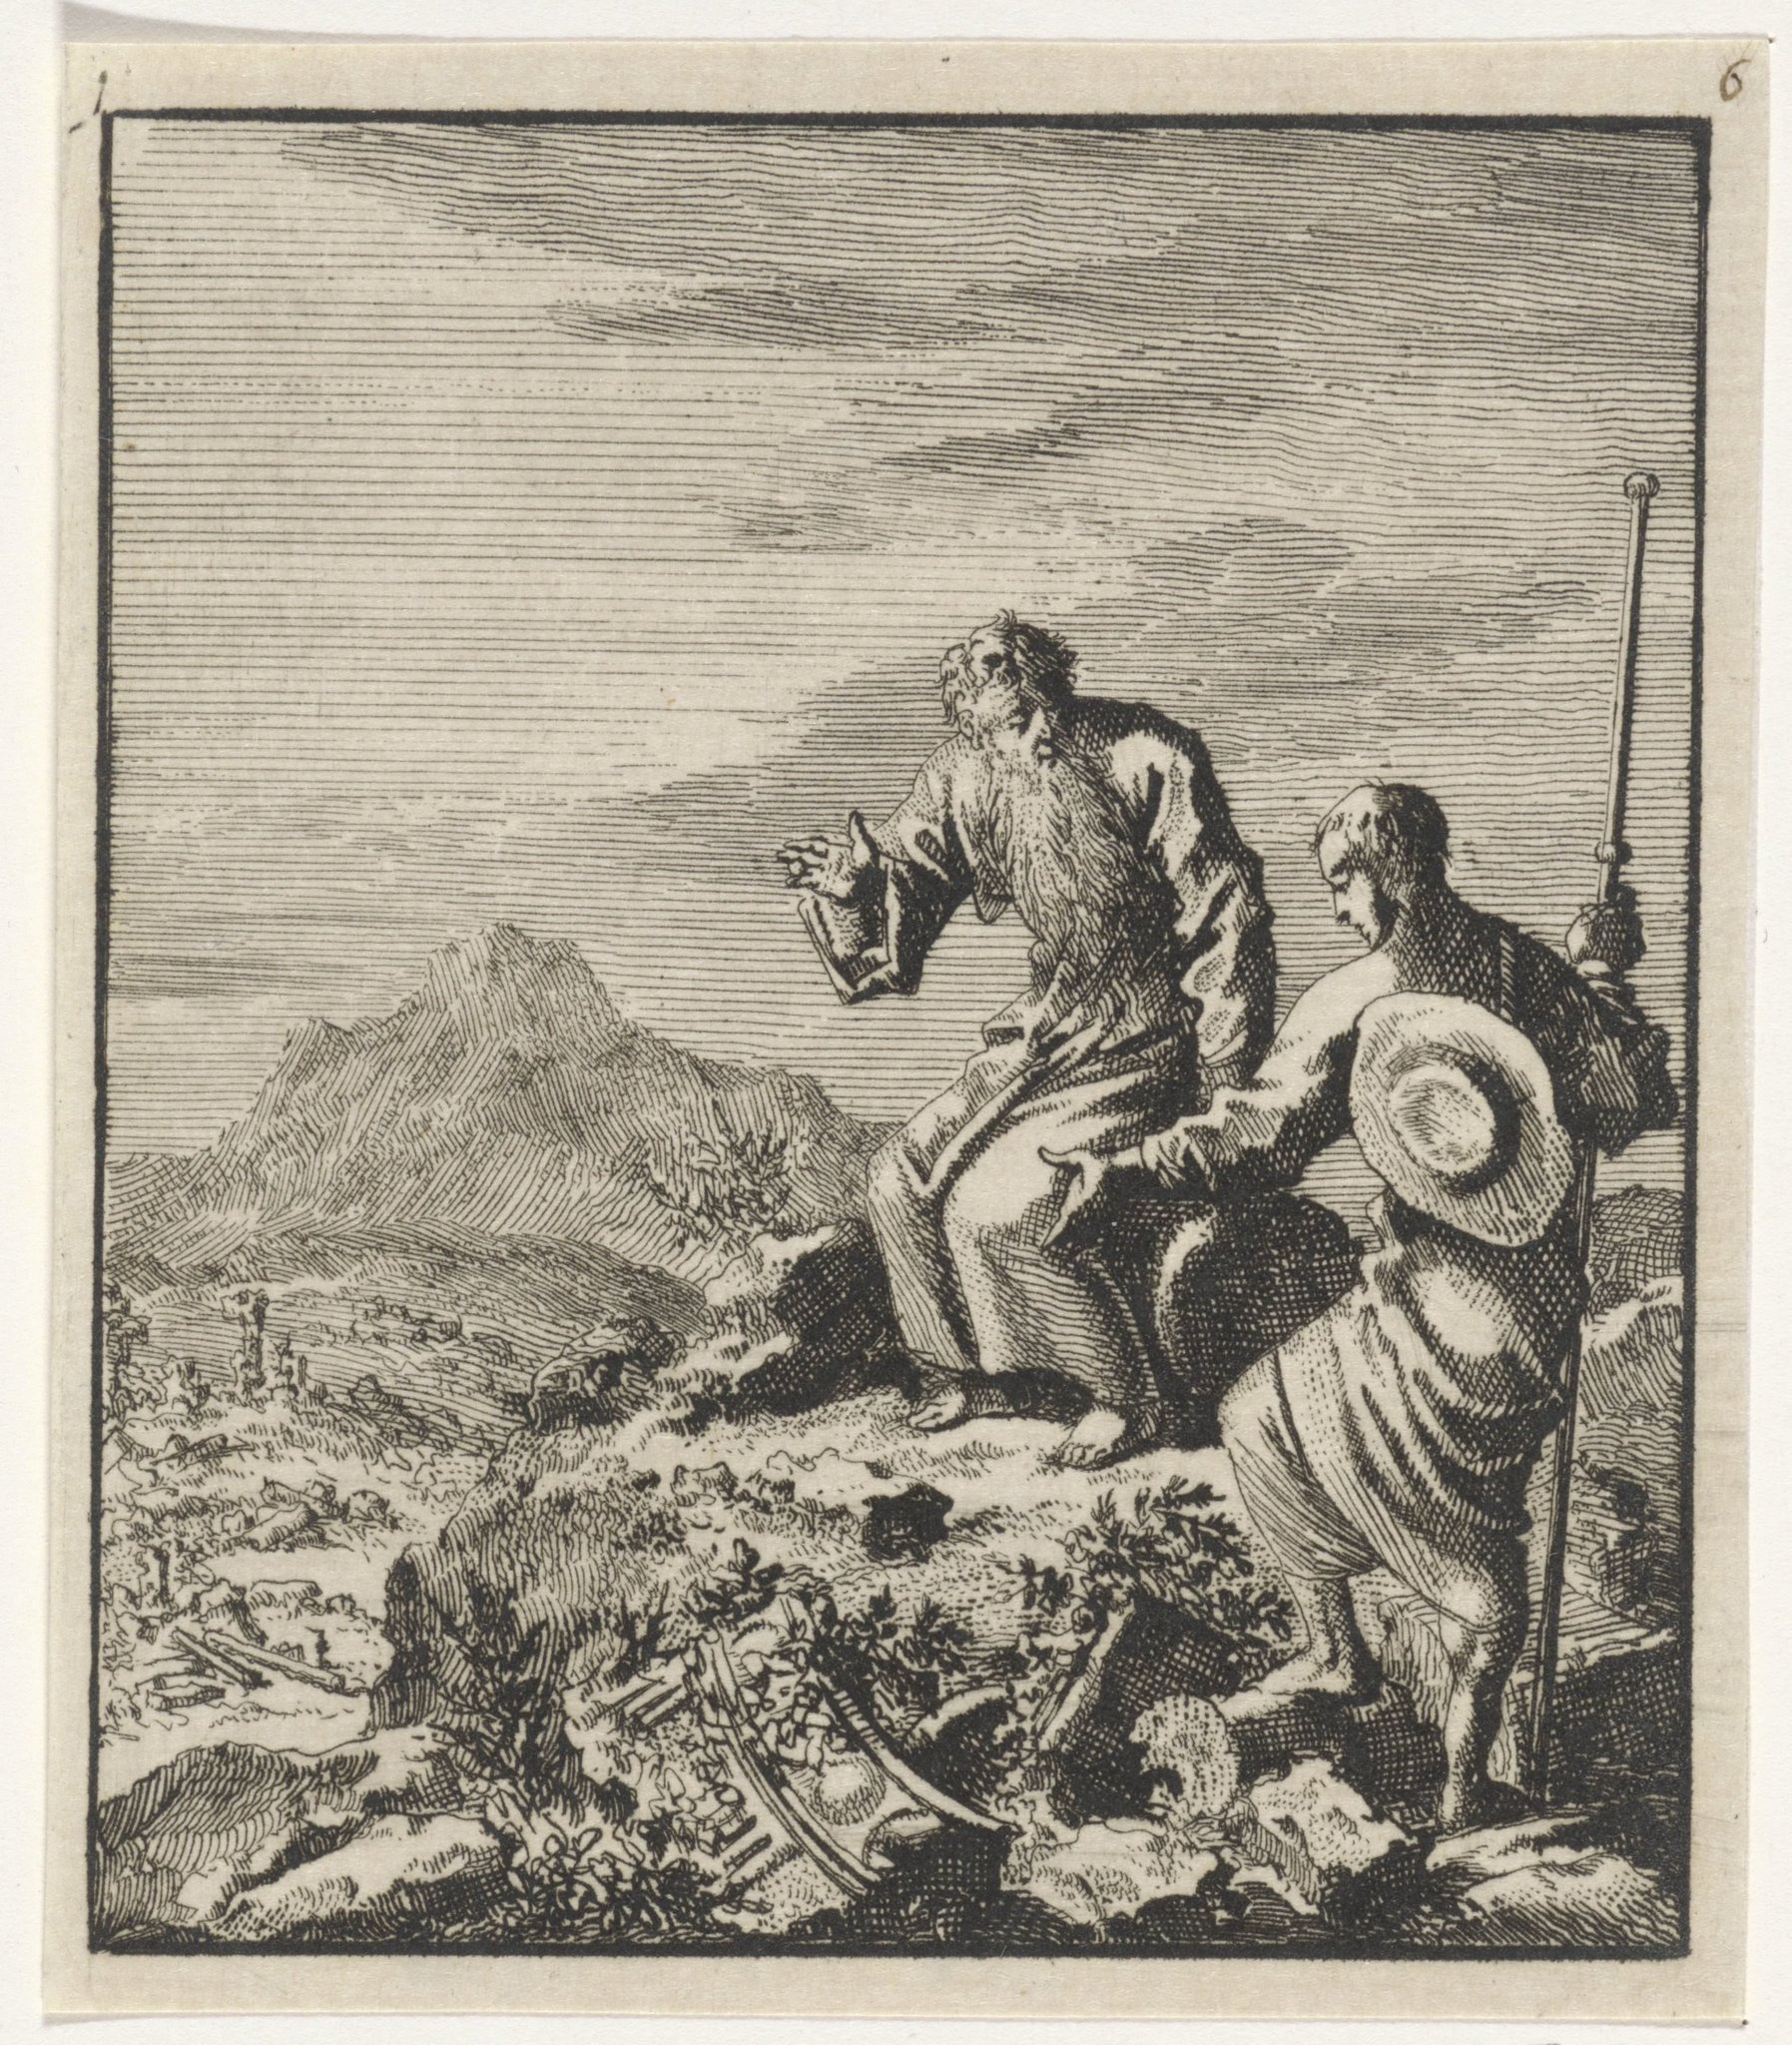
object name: print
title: Wandelende ziel vindt Simon Cleophas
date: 1706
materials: paper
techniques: etching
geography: amsterdam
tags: the soul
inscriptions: collector's mark: Lugt 2228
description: Illustratie voor: Schabaalje, Jean Philipsz. De vermeerderde lust-hof des gemoeds. Amsterdam: Jan Rieuwertsz. (II) en Barent Visscher, 1706, 145.